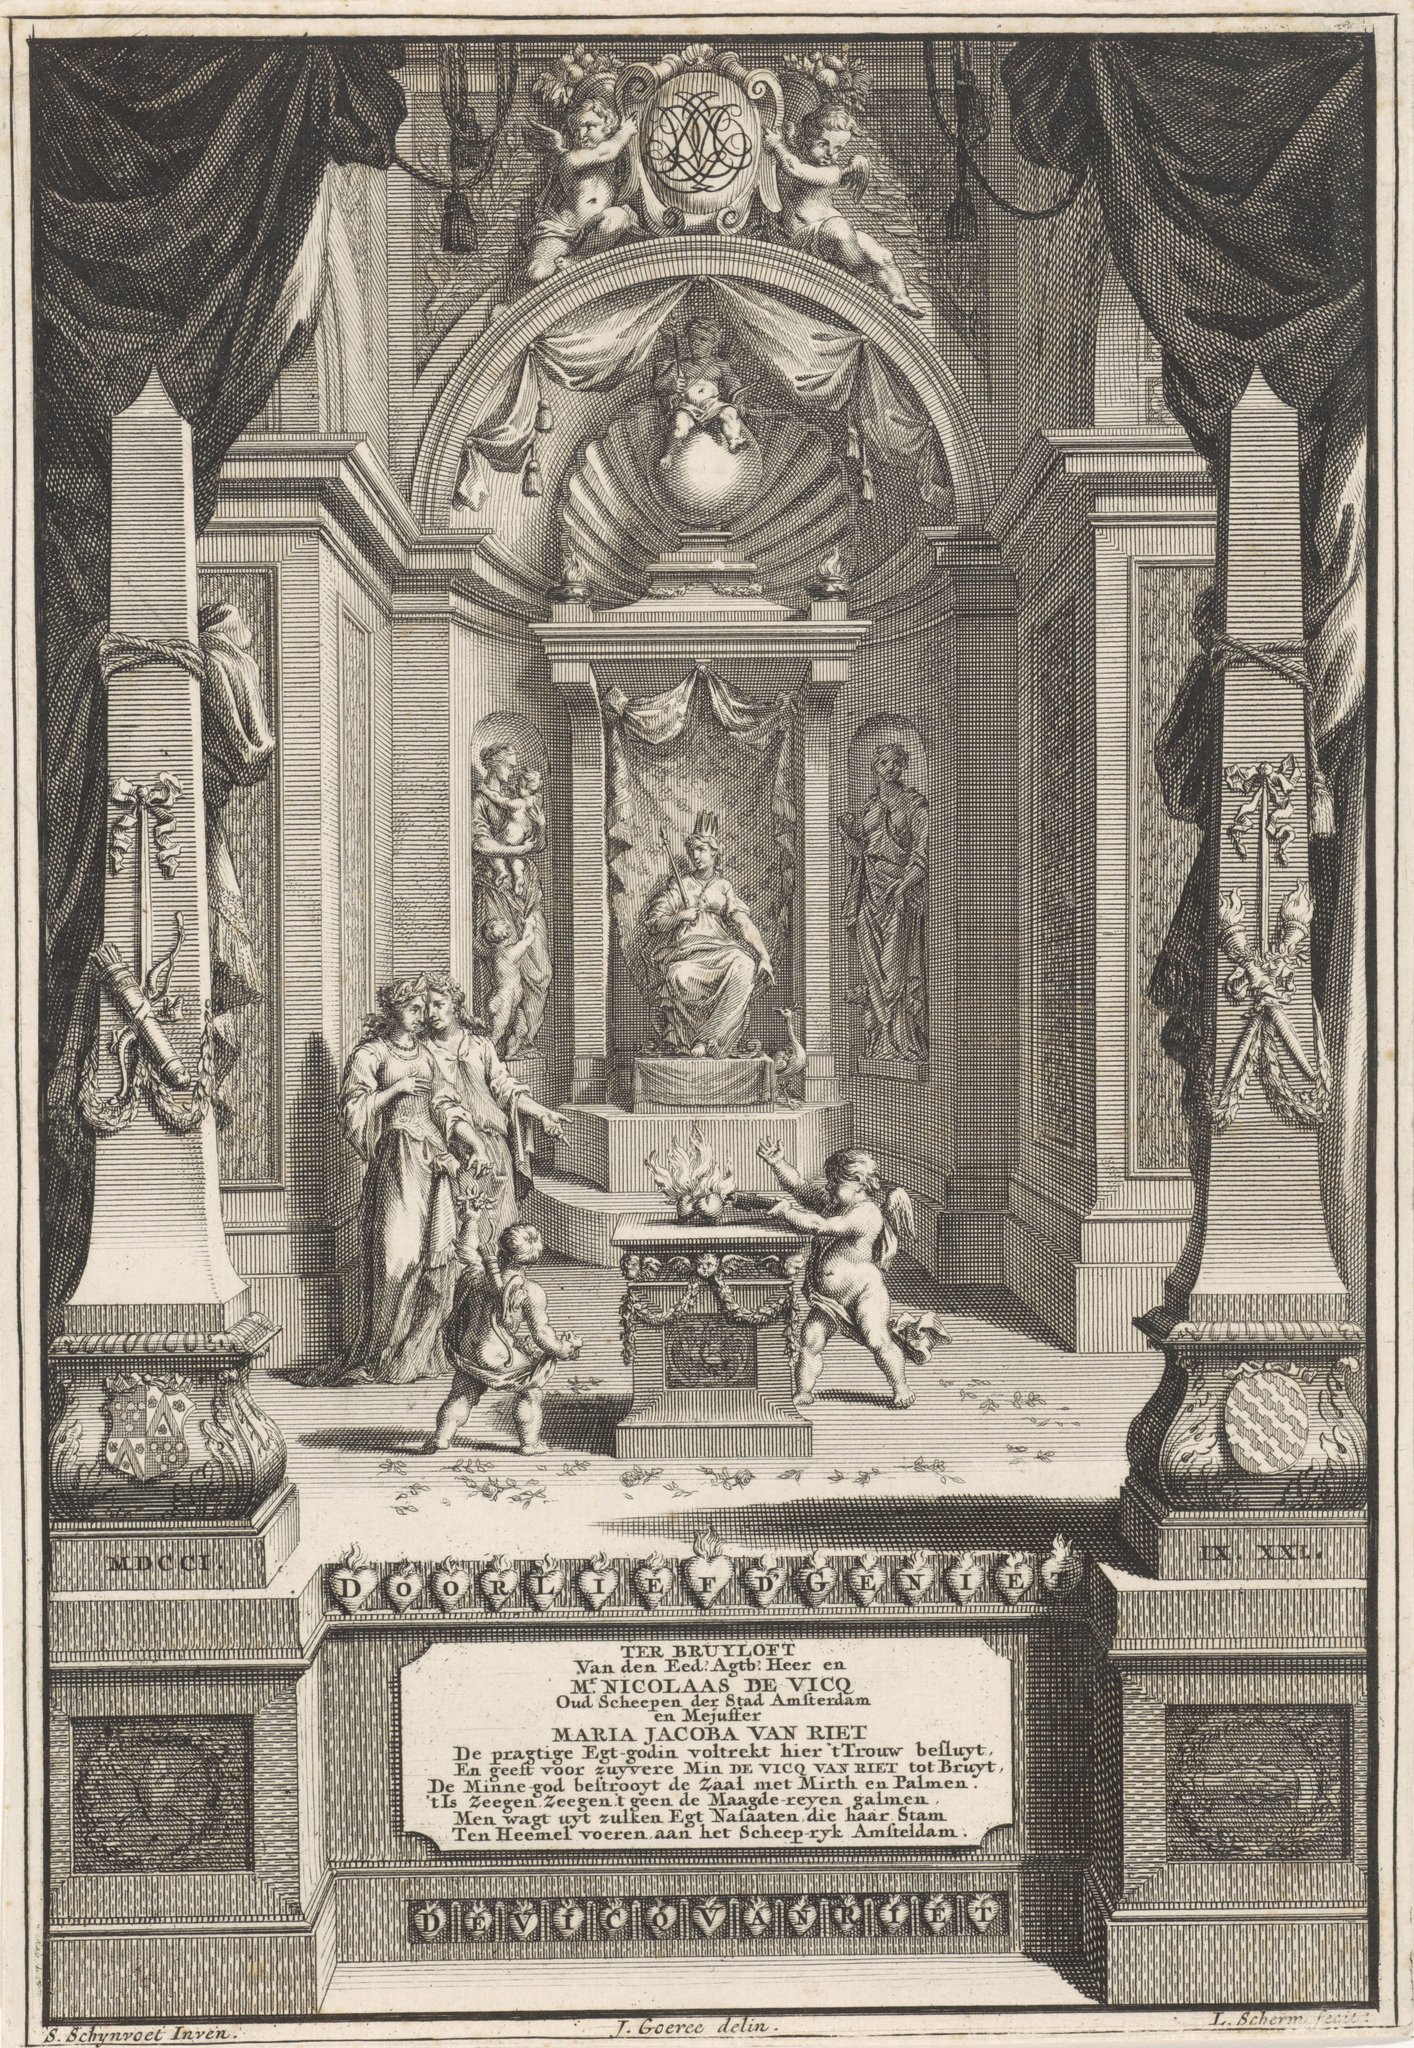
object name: book illustration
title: Monument ter ere van het huwelijk van Nicolaas de Vicq en Maria Jacoba van Riet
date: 1704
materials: paper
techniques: engraving, etching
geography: amsterdam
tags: specific aspects, allegorical aspects of juno; juno as patroness, obelisk, needle, (civil) marriage ceremonies, sacrifice ~ non-christian religions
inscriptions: collector's mark: Lugt 2228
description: Huwelijksprent met een monument ter ere van het huwelijk van Nicolaas de Vicq en Maria Jacoba van Riet. In het midden troont Juno als godin van het huwelijk. Ze wordt geflankeerd door twee beelden van vrouwen, waarvan één met twee kinderen is weergegeven. Boven haar enkele putti, van wie twee aan weerszijden van het monogram van het huwelijkspaar zitten. Voor Juno offeren twee amoretti op het altaar van de liefde met brandende harten. Links het huwelijkspaar. Vooraan twee obeslisken met links een pijlkoker en een boog, de attributen van Amor, en rechts een obelisk met twee brandende fakkels als liefdessymbolen. Onderaan de huwelijksdatum in Romeinse cijfers: 1701-09-21. Midden onder een tekst in brandende harten en een twaalfregelige tekst in het Nederlands over het bruidspaar en de prent.